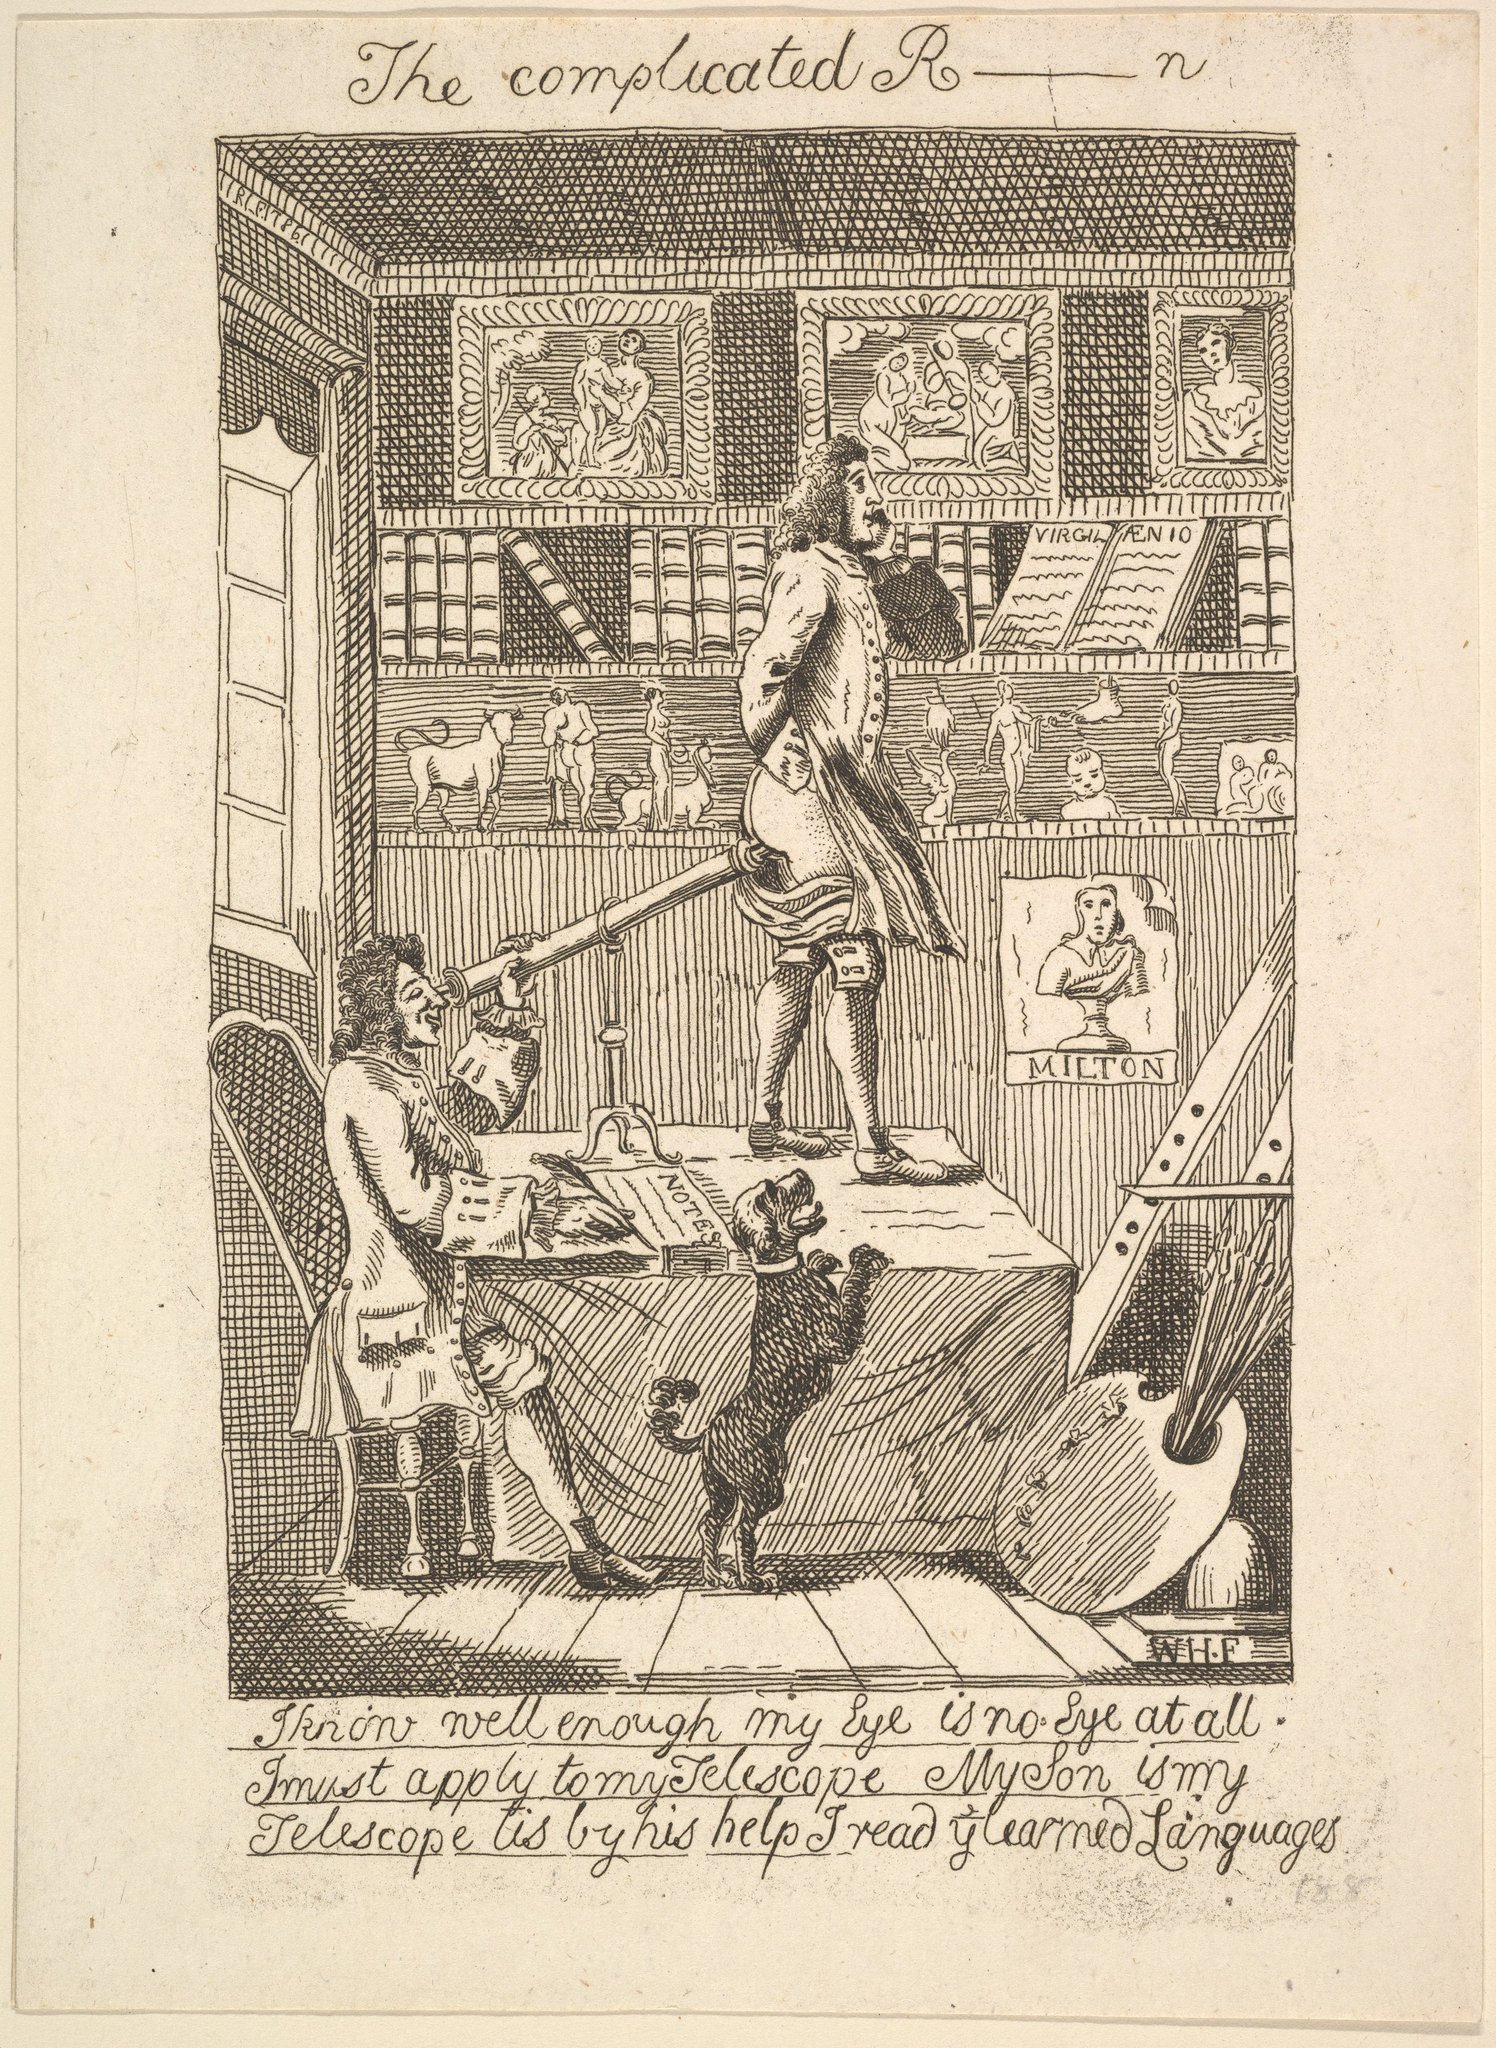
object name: print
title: The Complicated R_____n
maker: richard livesay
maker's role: artist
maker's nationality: british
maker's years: 1750-1826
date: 1794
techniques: etching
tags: satire,men,dogs,telescopes